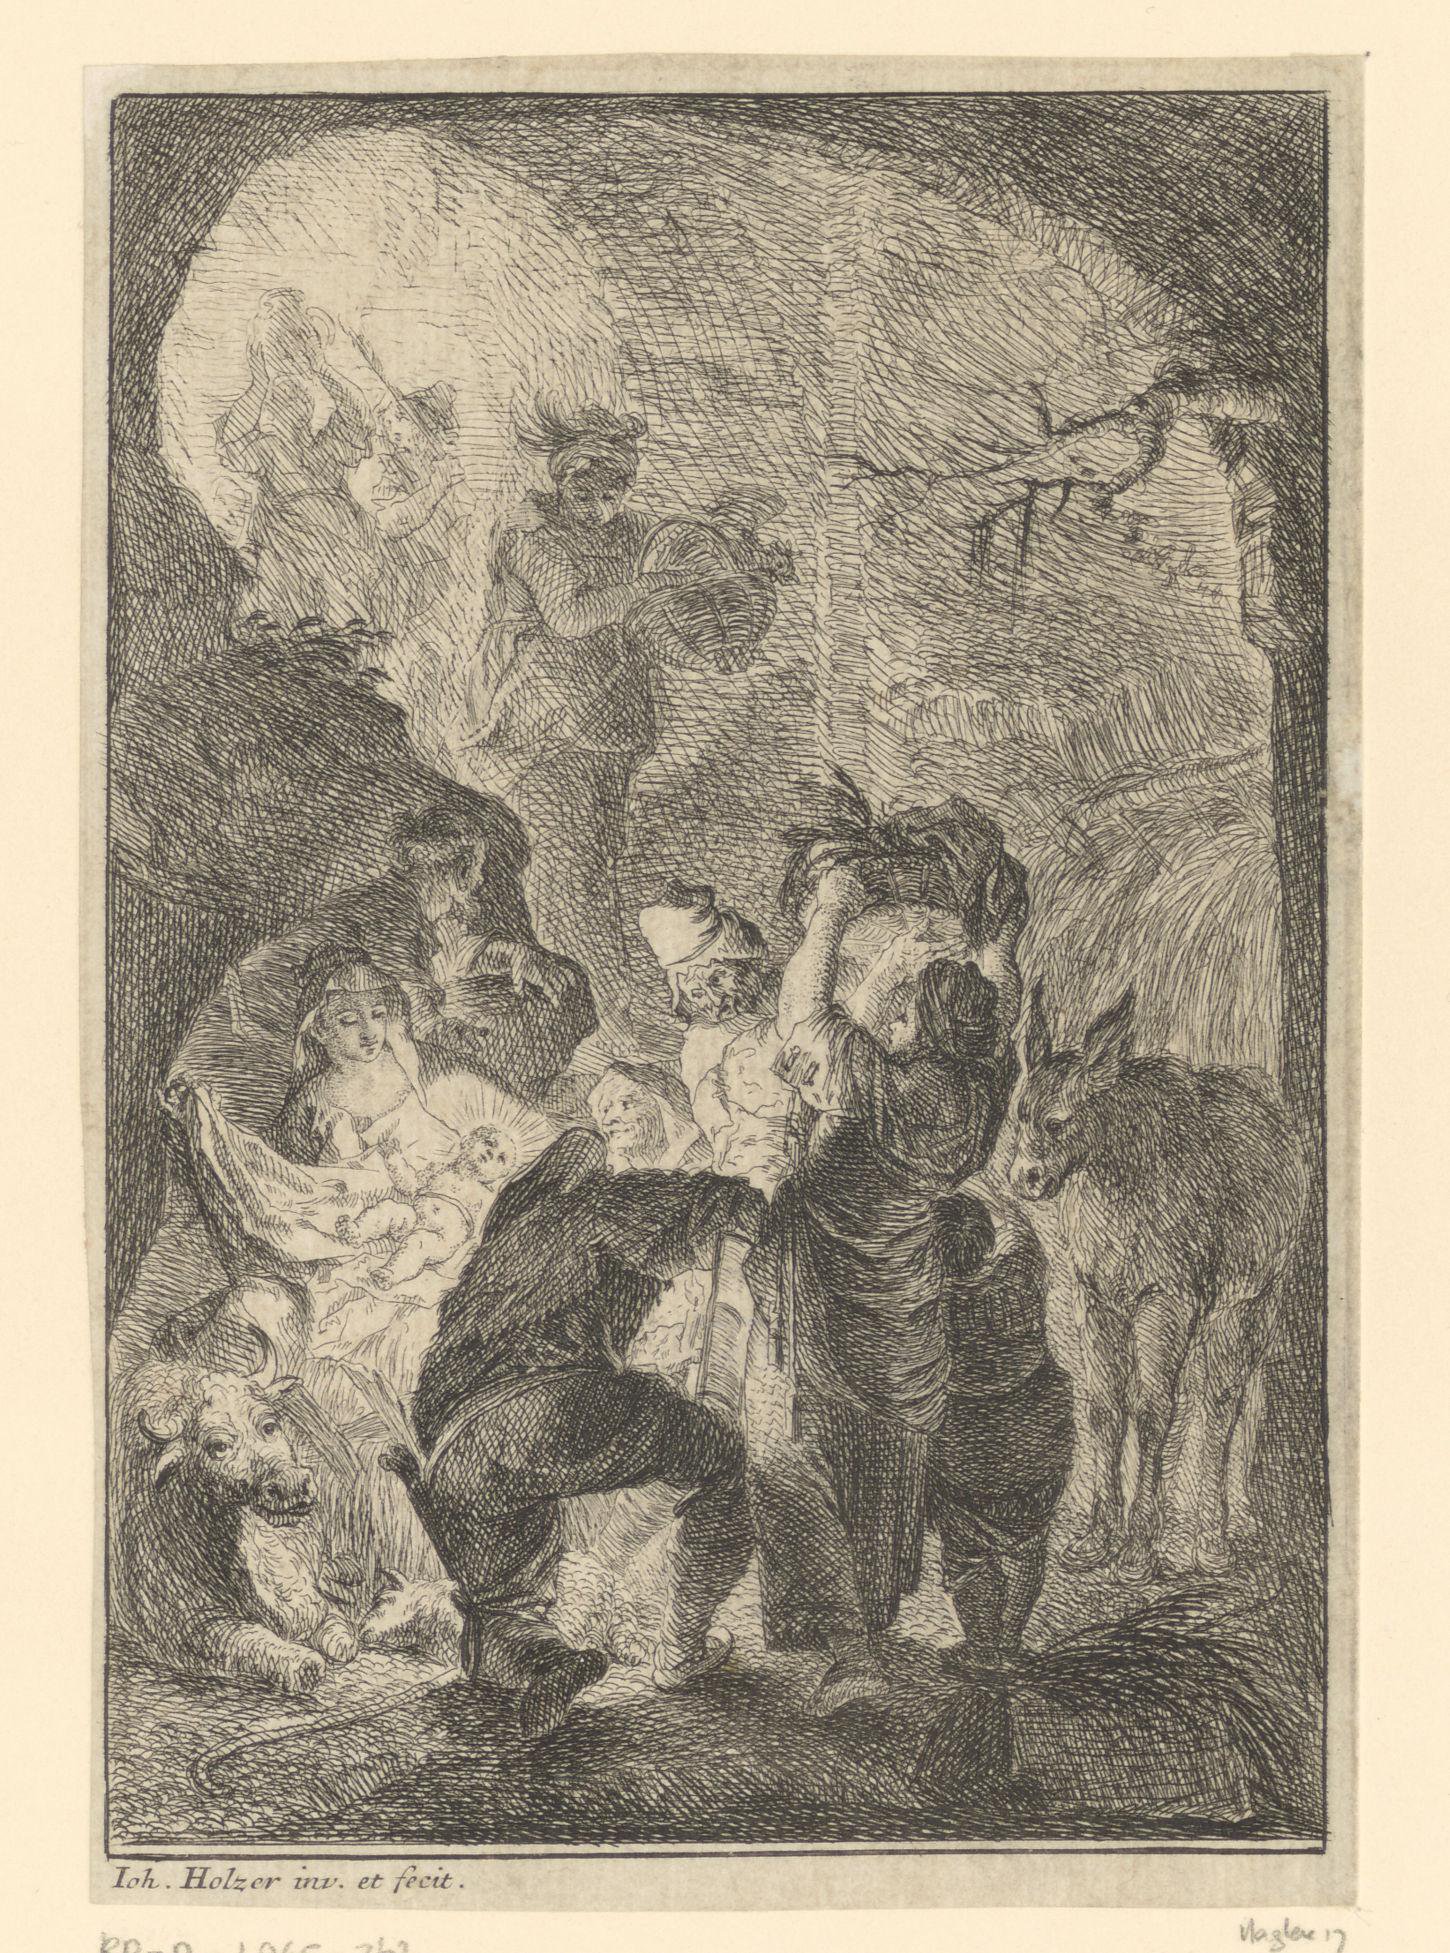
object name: print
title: Aanbidding der herders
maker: johann evangelist holzer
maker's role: print maker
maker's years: 1709-1740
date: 1719-1740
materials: paper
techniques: etching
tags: adoration of the christ-child by the shepherds; mary and joseph present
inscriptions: collector's mark: Lugt 2228, collector's mark: Lugt 2760